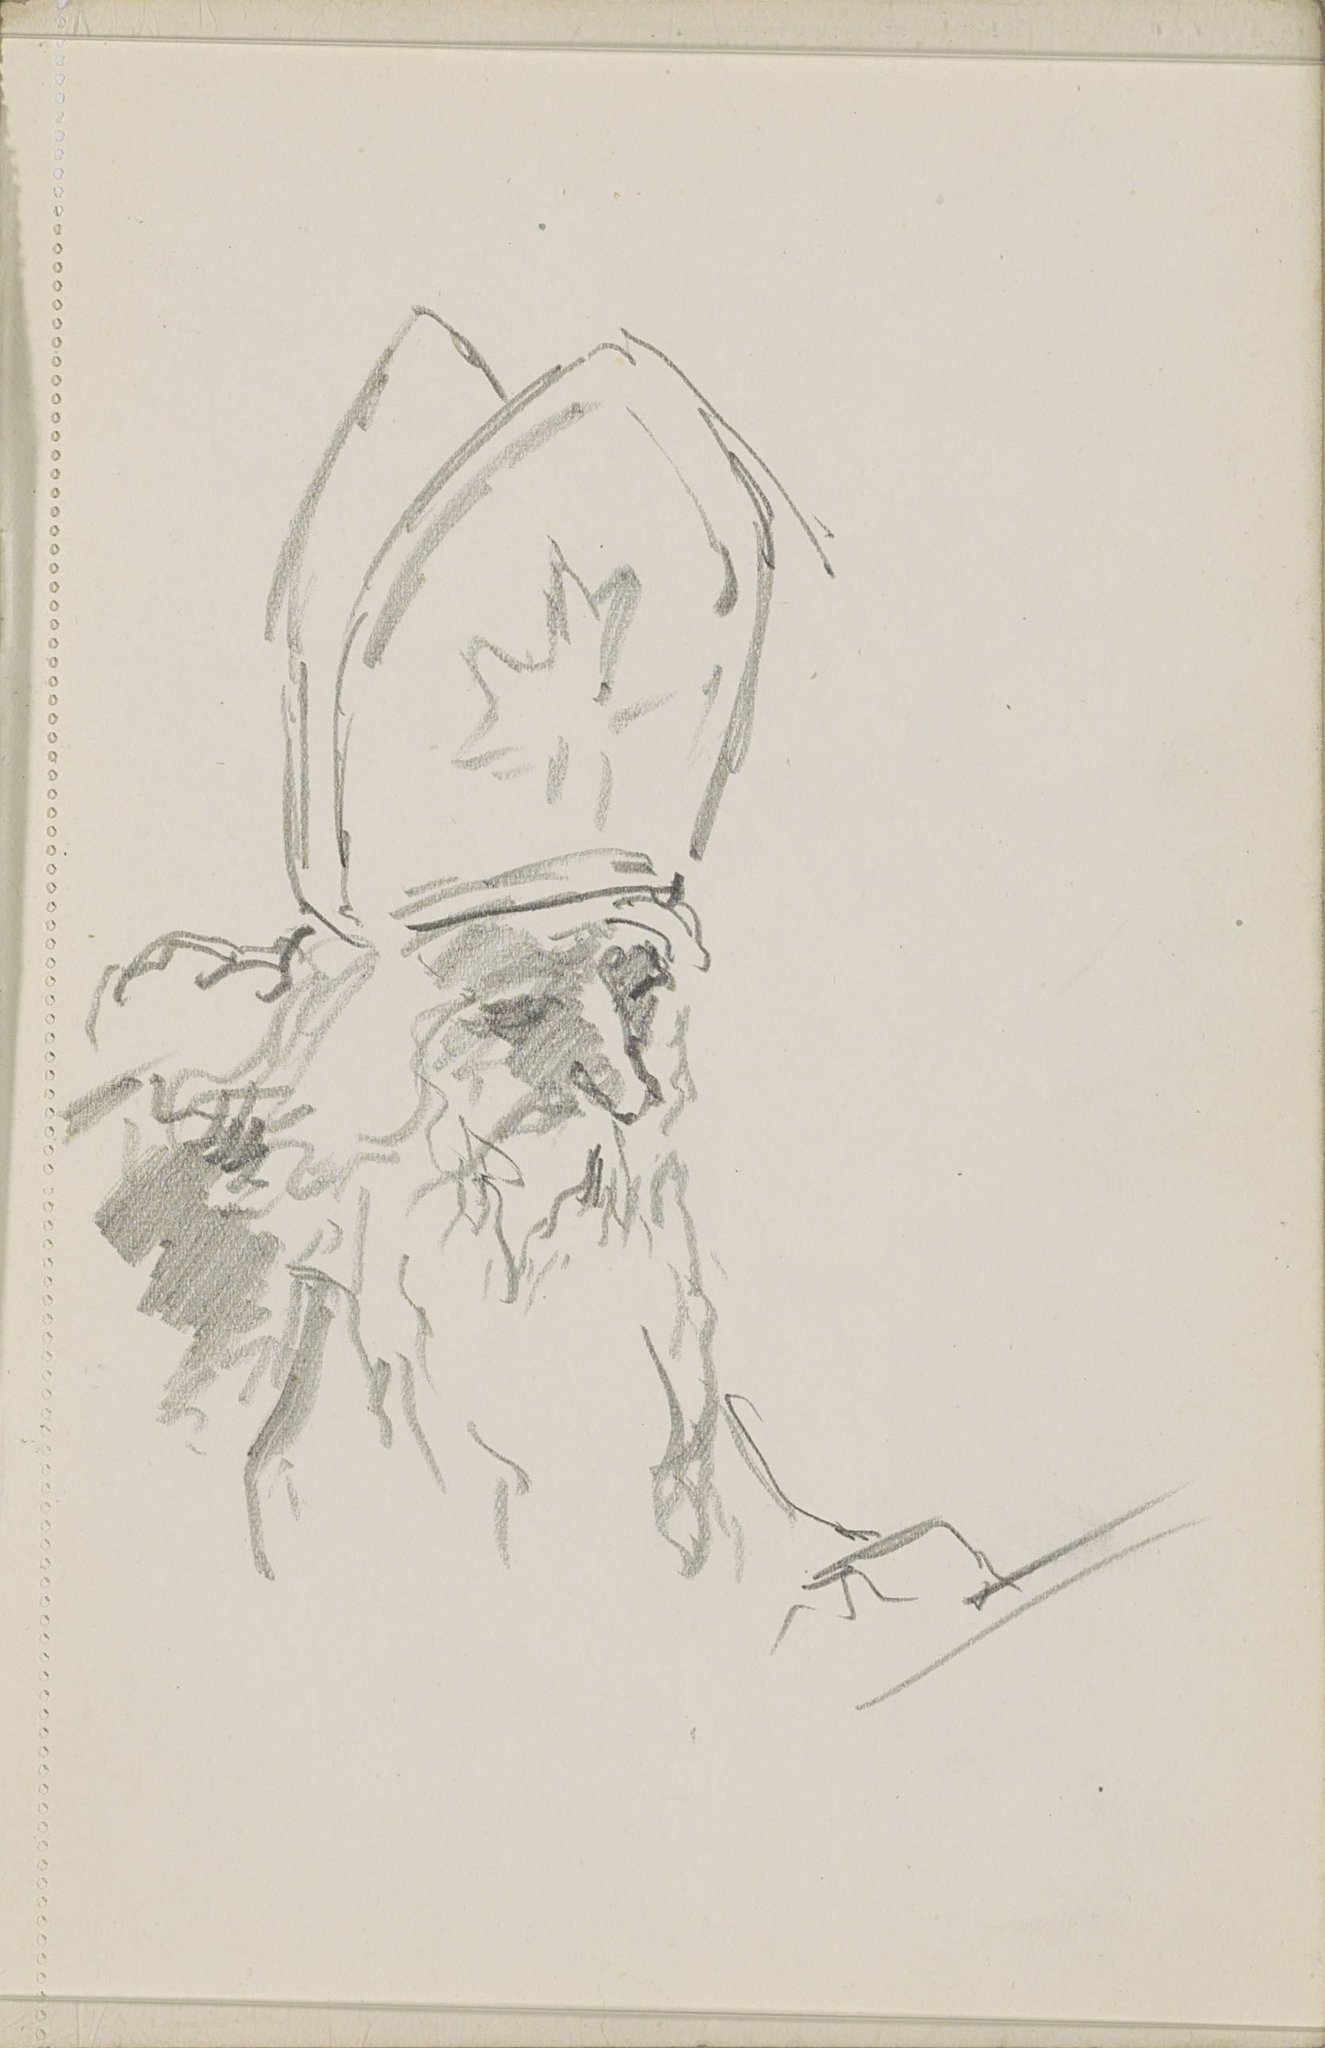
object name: sketchbook leaf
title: Sint Nicolaas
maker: cornelis vreedenburgh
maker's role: draughtsman, print maker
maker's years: 1880-1946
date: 1890-1946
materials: paper, pencil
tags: the bishop nicholas of myra (or bari); possible attributes: anchor, boat, three golden balls (on a book), three purses, three children in a tub, three maidens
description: Blad 14 recto uit een schetsboek met 61 bladen.